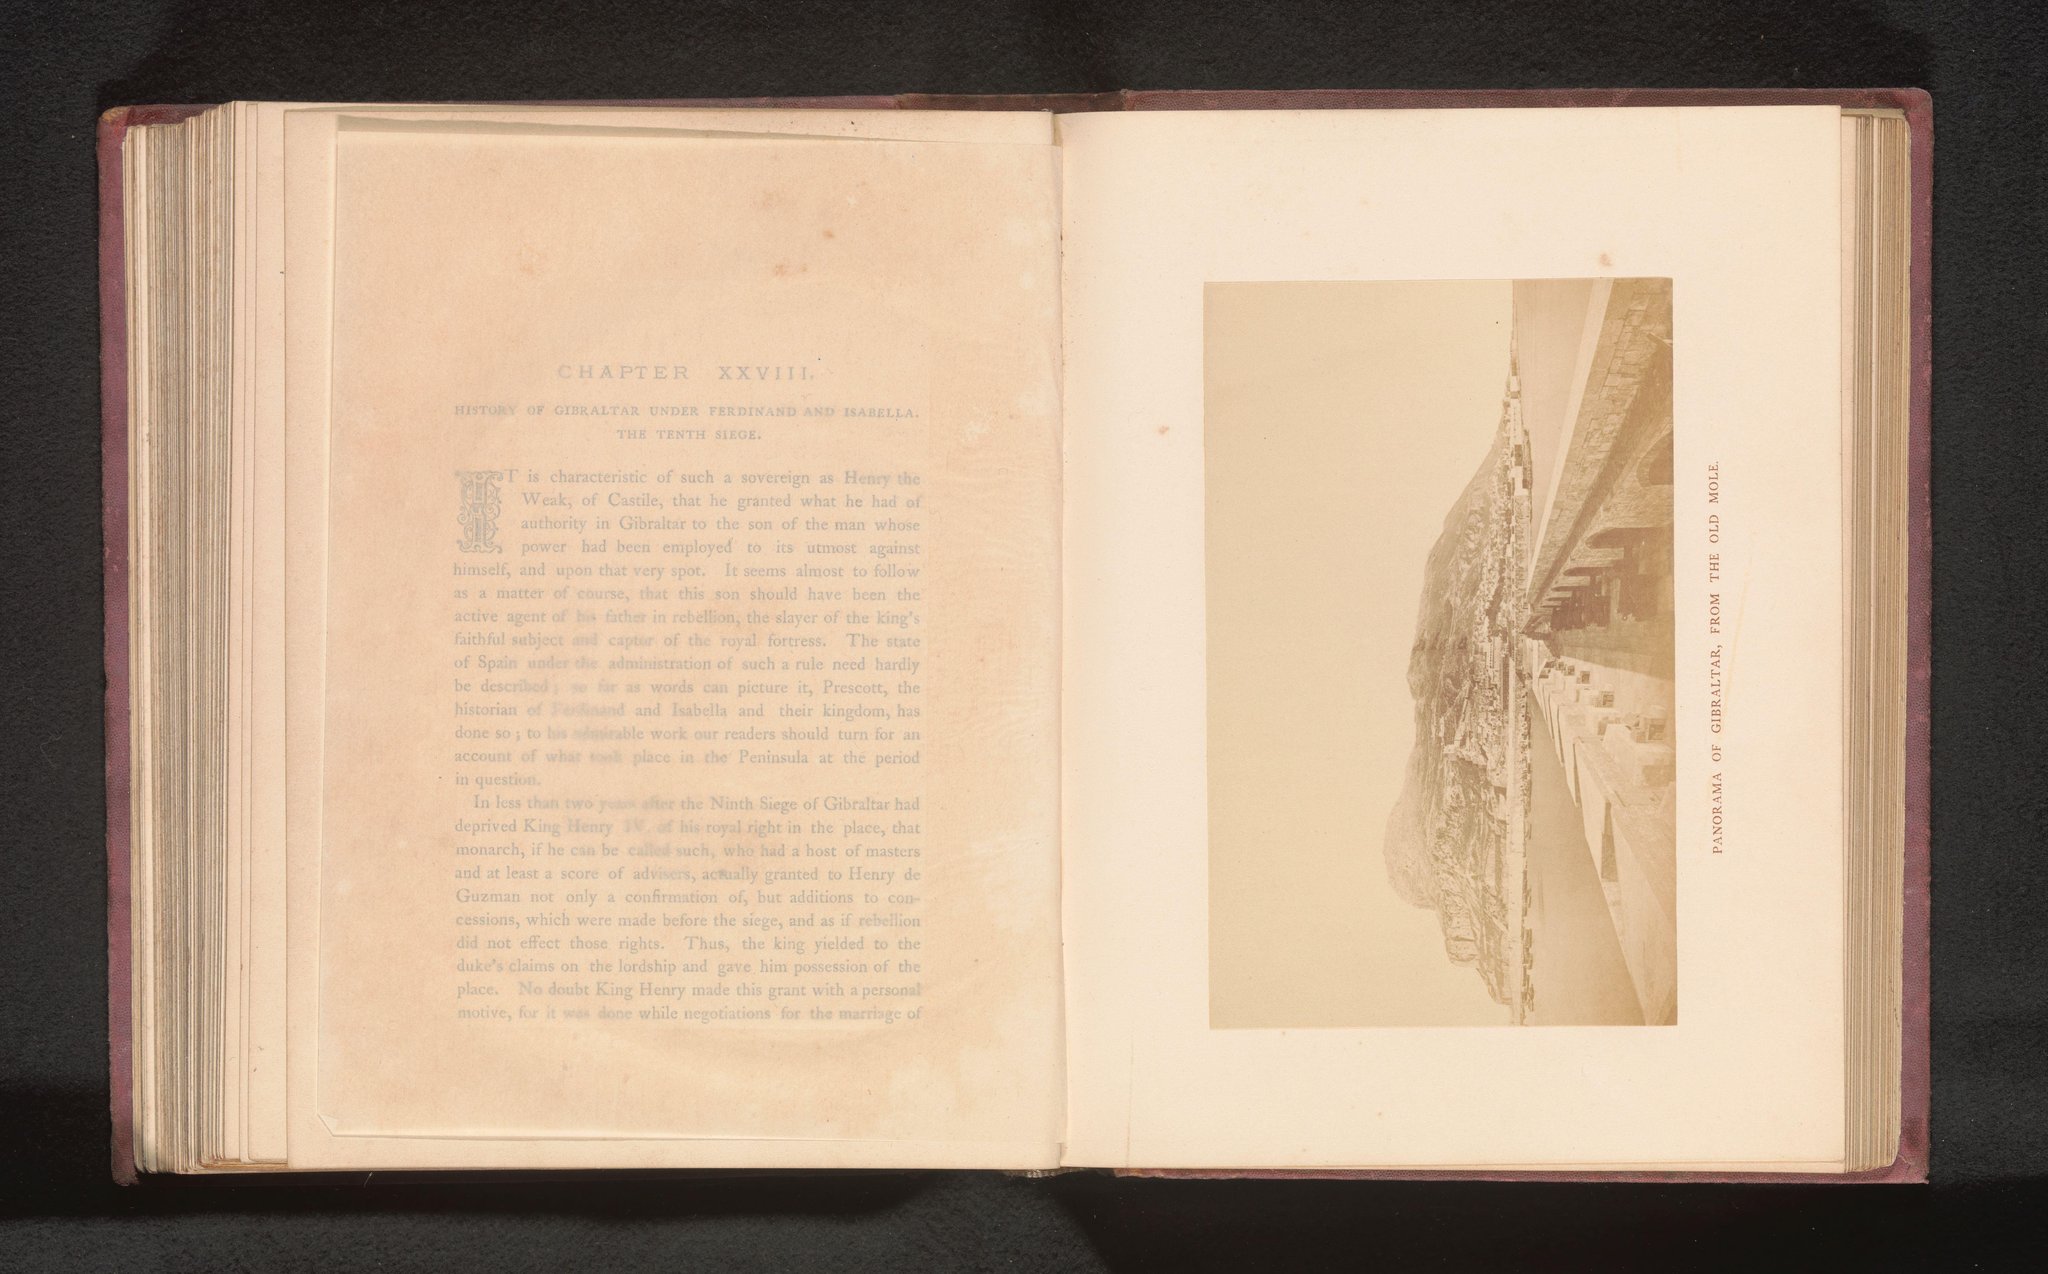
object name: photograph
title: Panorama of Gibraltar, from the old mole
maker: j.h. mann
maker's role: fotograaf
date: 1860-1870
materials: photographic support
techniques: albumen print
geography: gibraltar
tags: city-view in general; 'veduta'